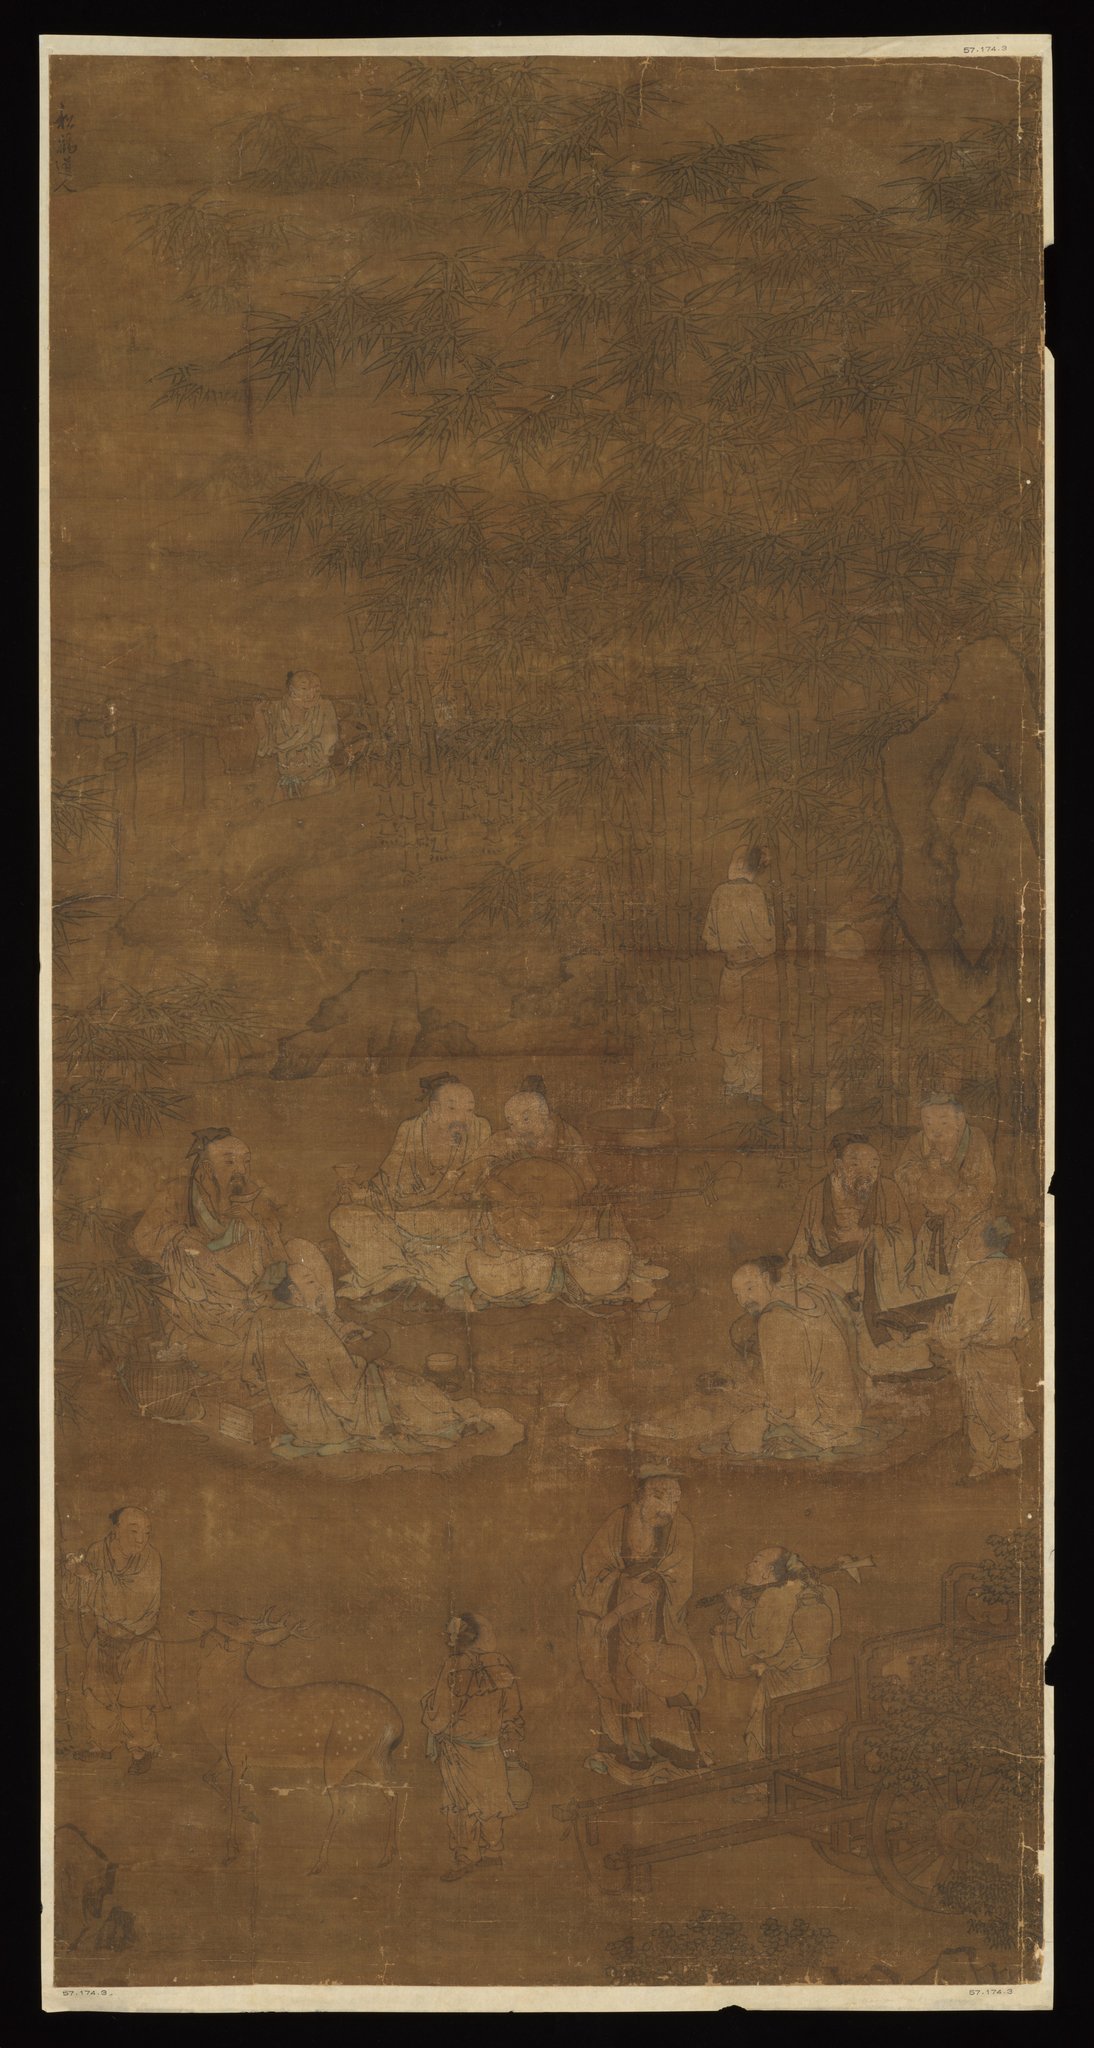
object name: hanging scroll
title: Sages in a Bamboo Grove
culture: chinese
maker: unidentified artist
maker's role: artist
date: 1368-1911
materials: ink, silk